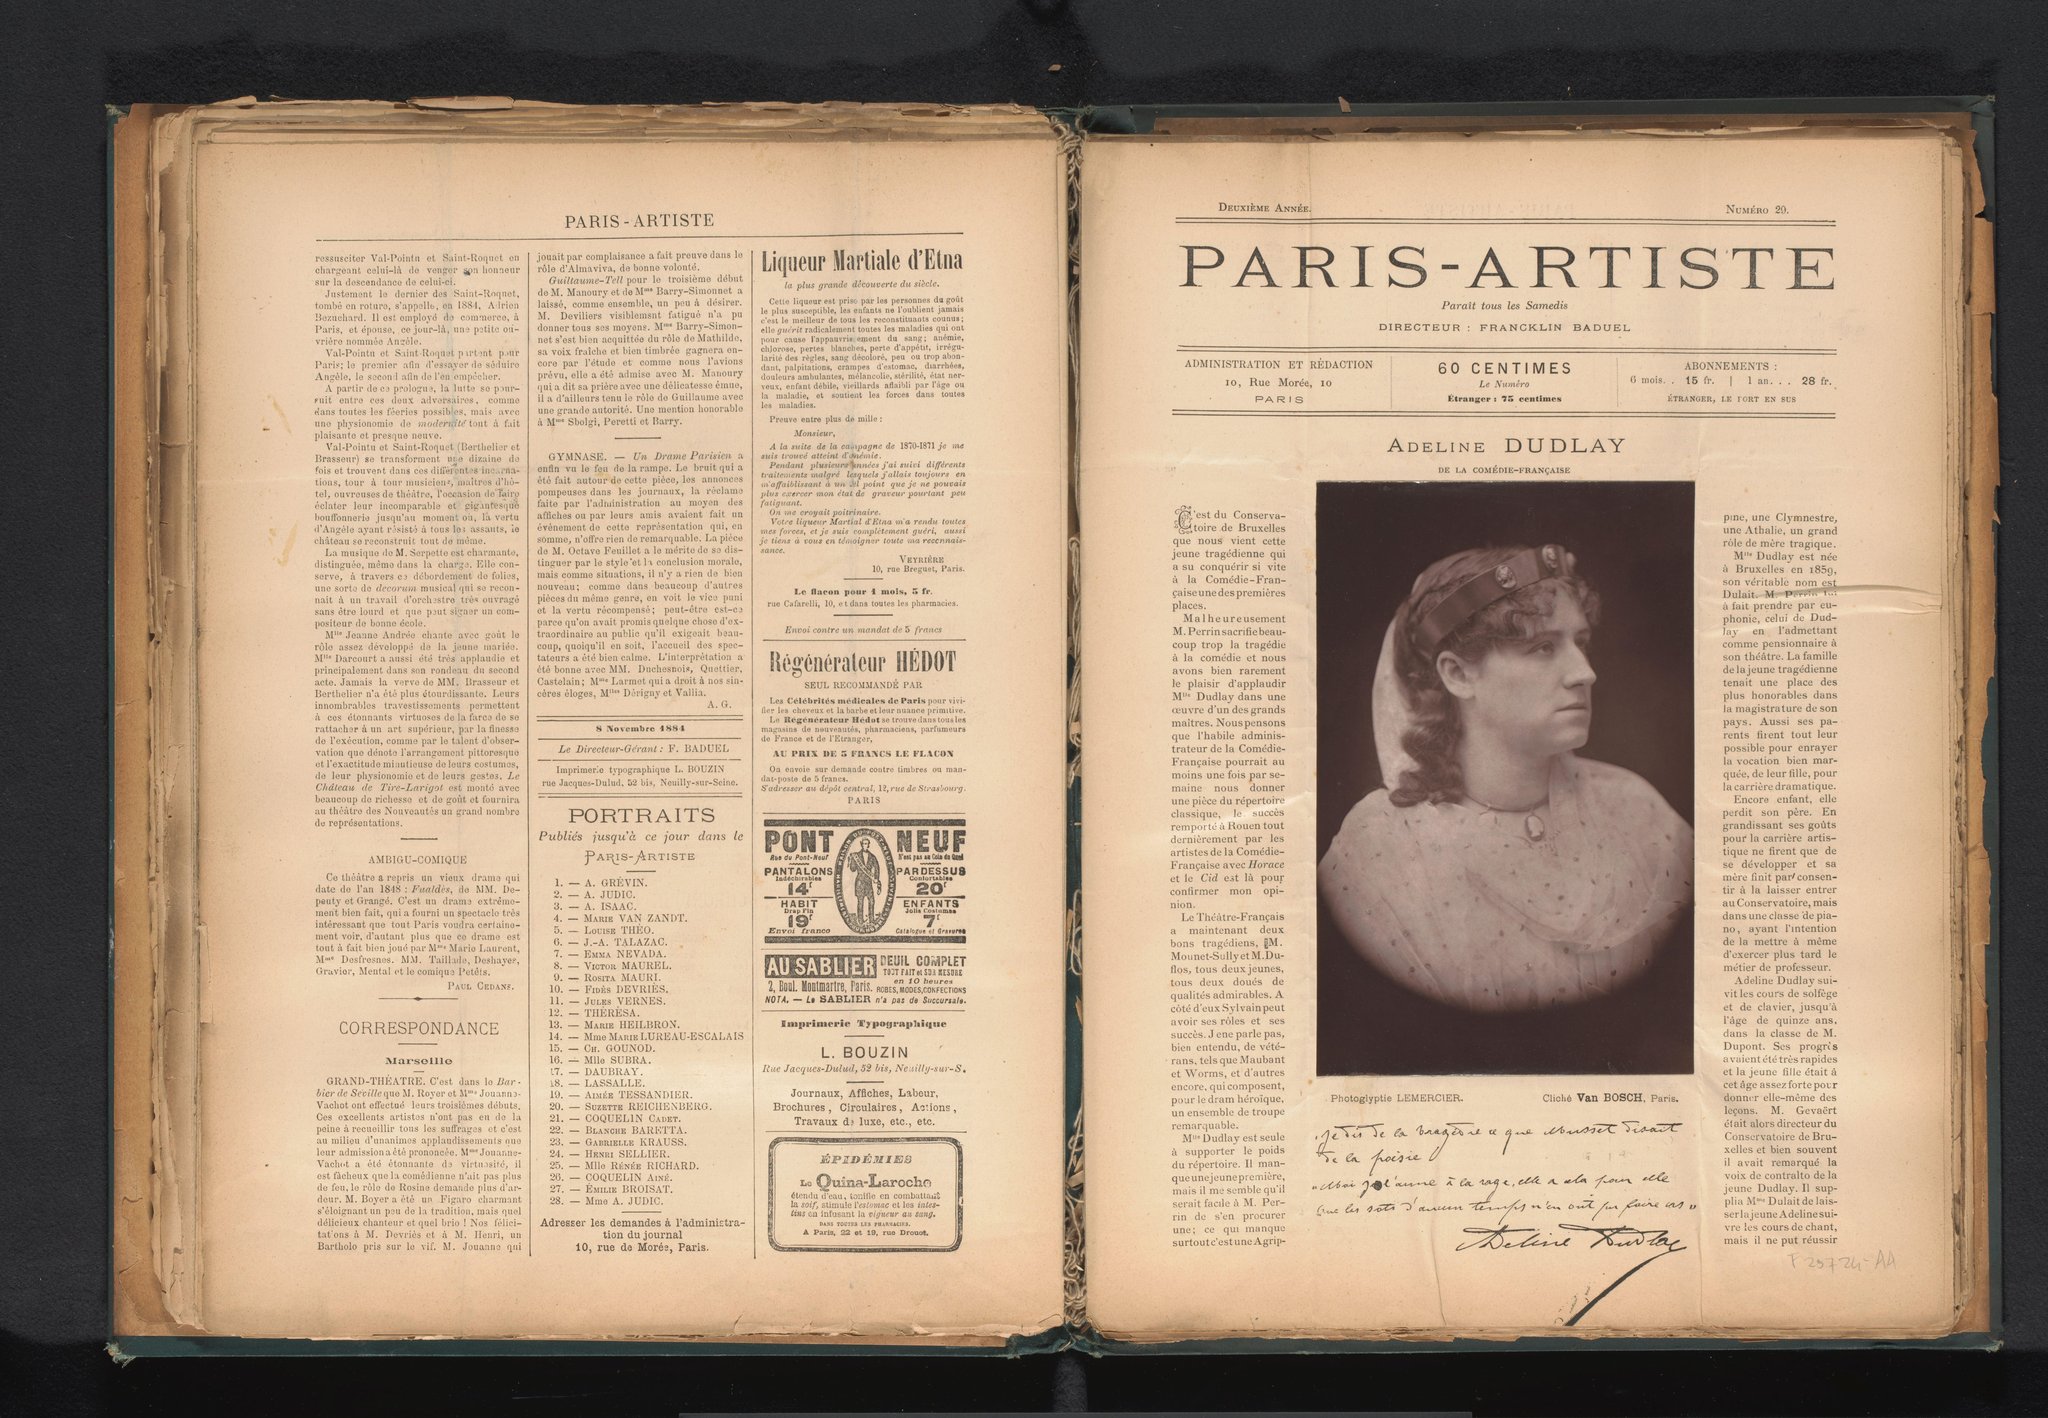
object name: page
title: Portret van Adeline Dudlay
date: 1880-1884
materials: paper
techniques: woodburytype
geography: paris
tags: brussels, paris, historical persons - bb - woman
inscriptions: inscription: ‘De la comédie-Française’